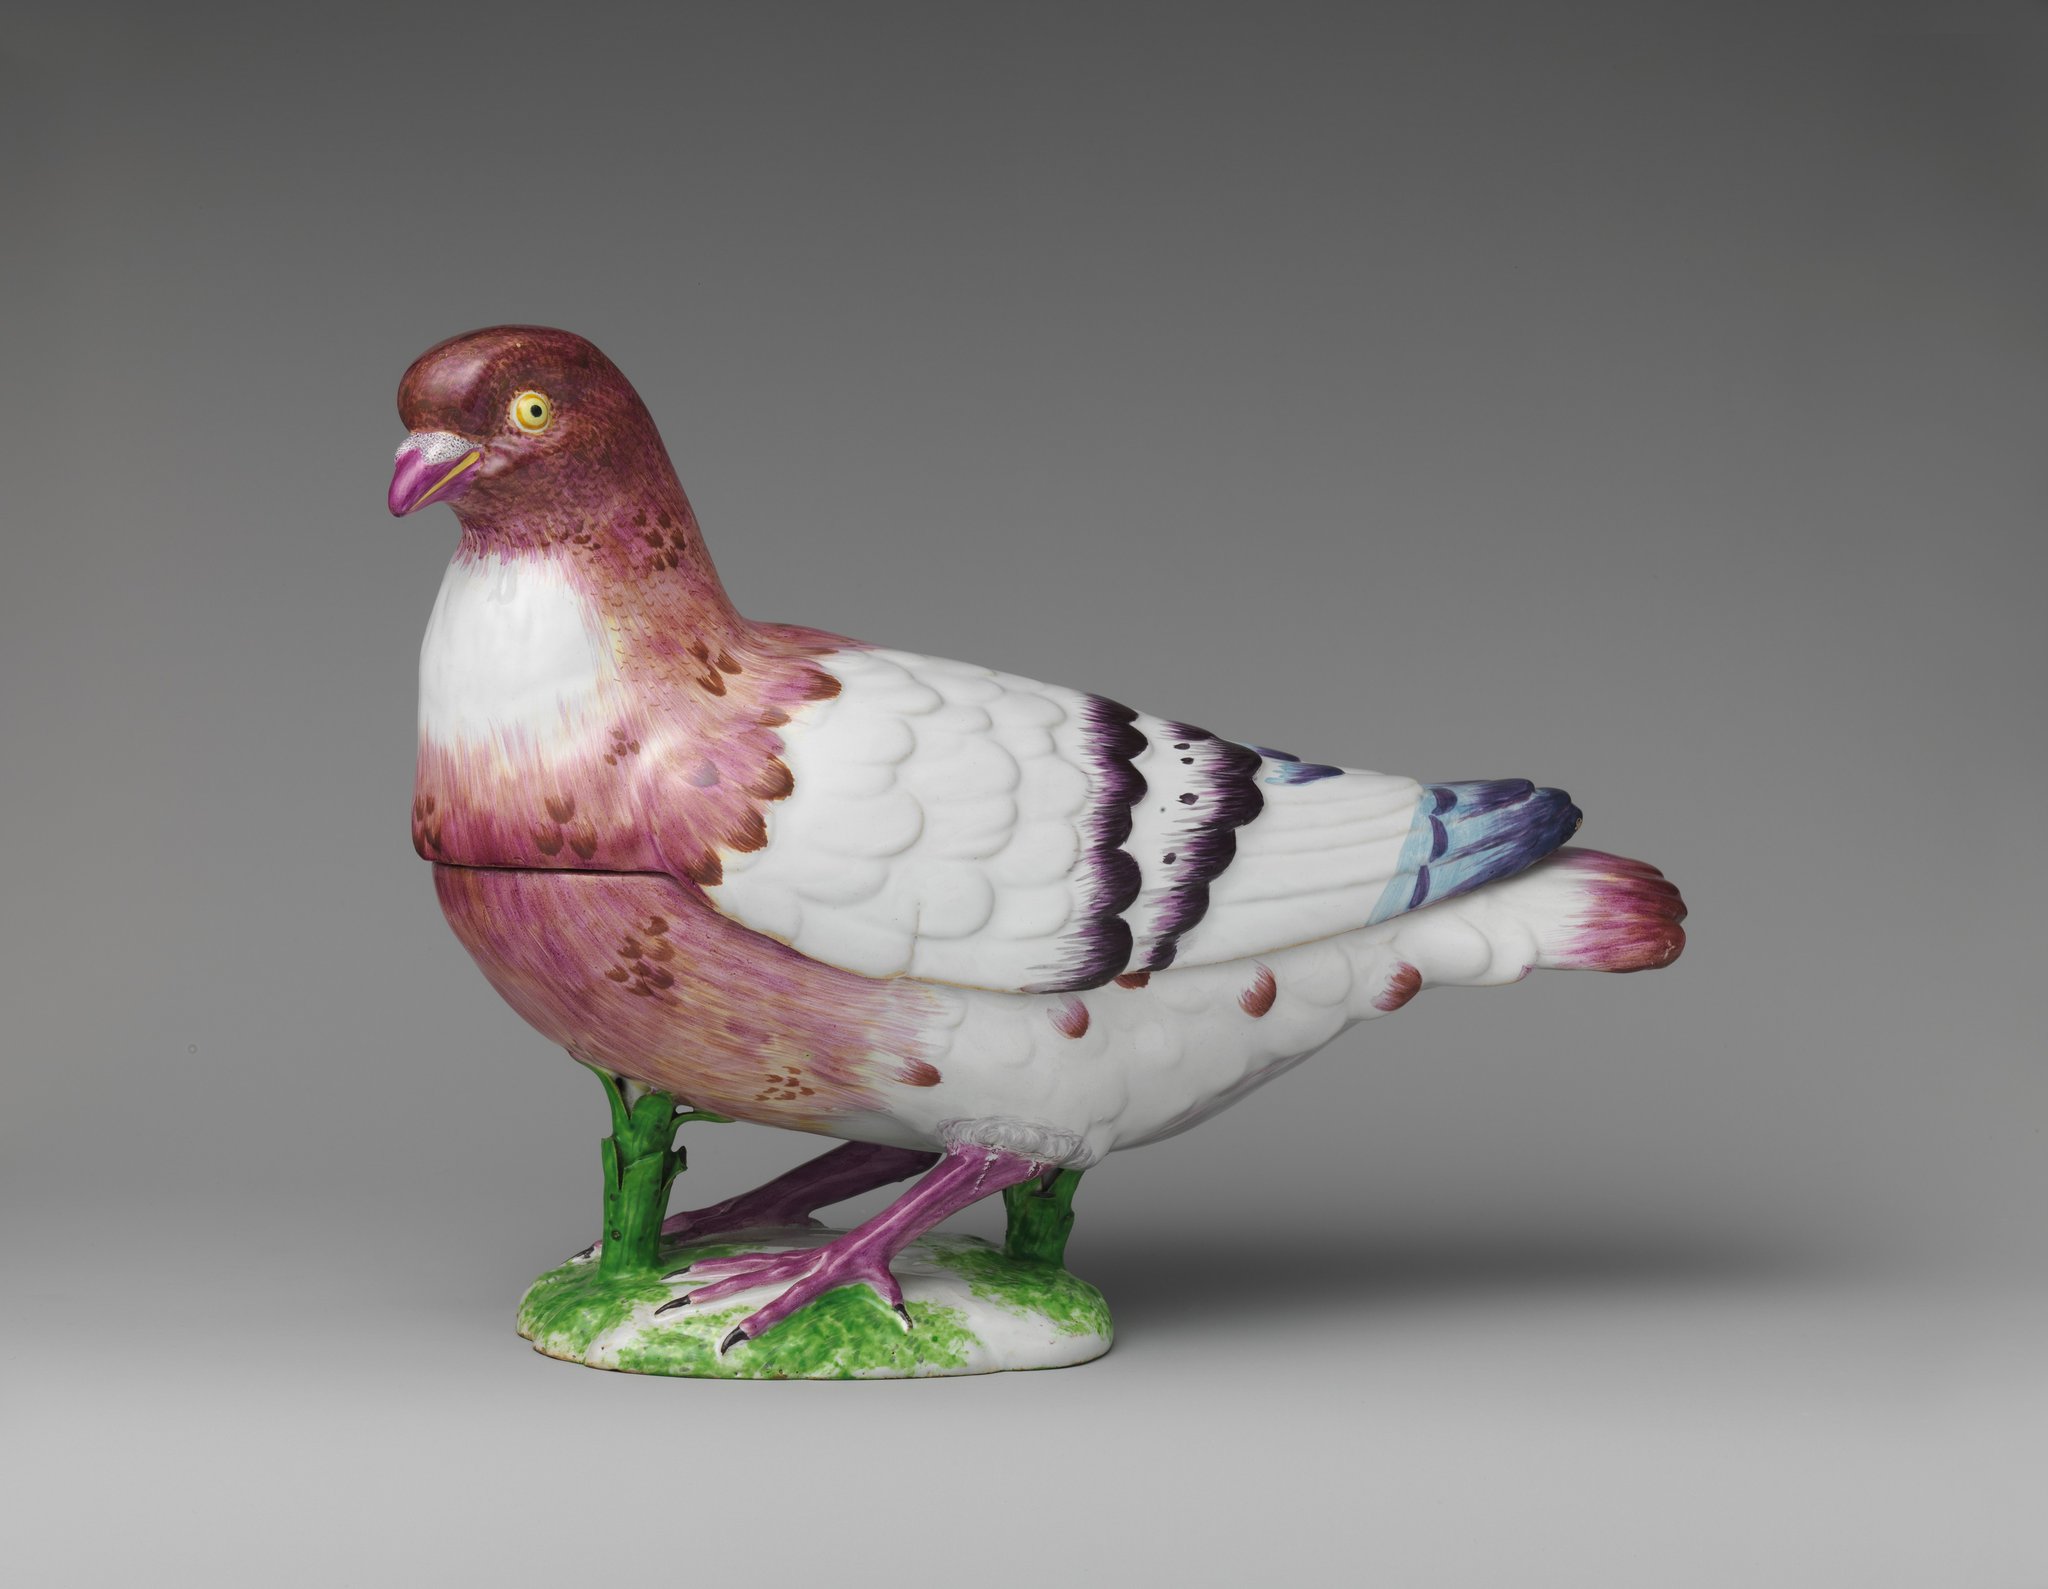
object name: tureen with cover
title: Tureen with cover in the form of a pigeon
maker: paul hannong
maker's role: factory owner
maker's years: 1755-1759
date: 1750-1760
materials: faience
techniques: glazing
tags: pigeons